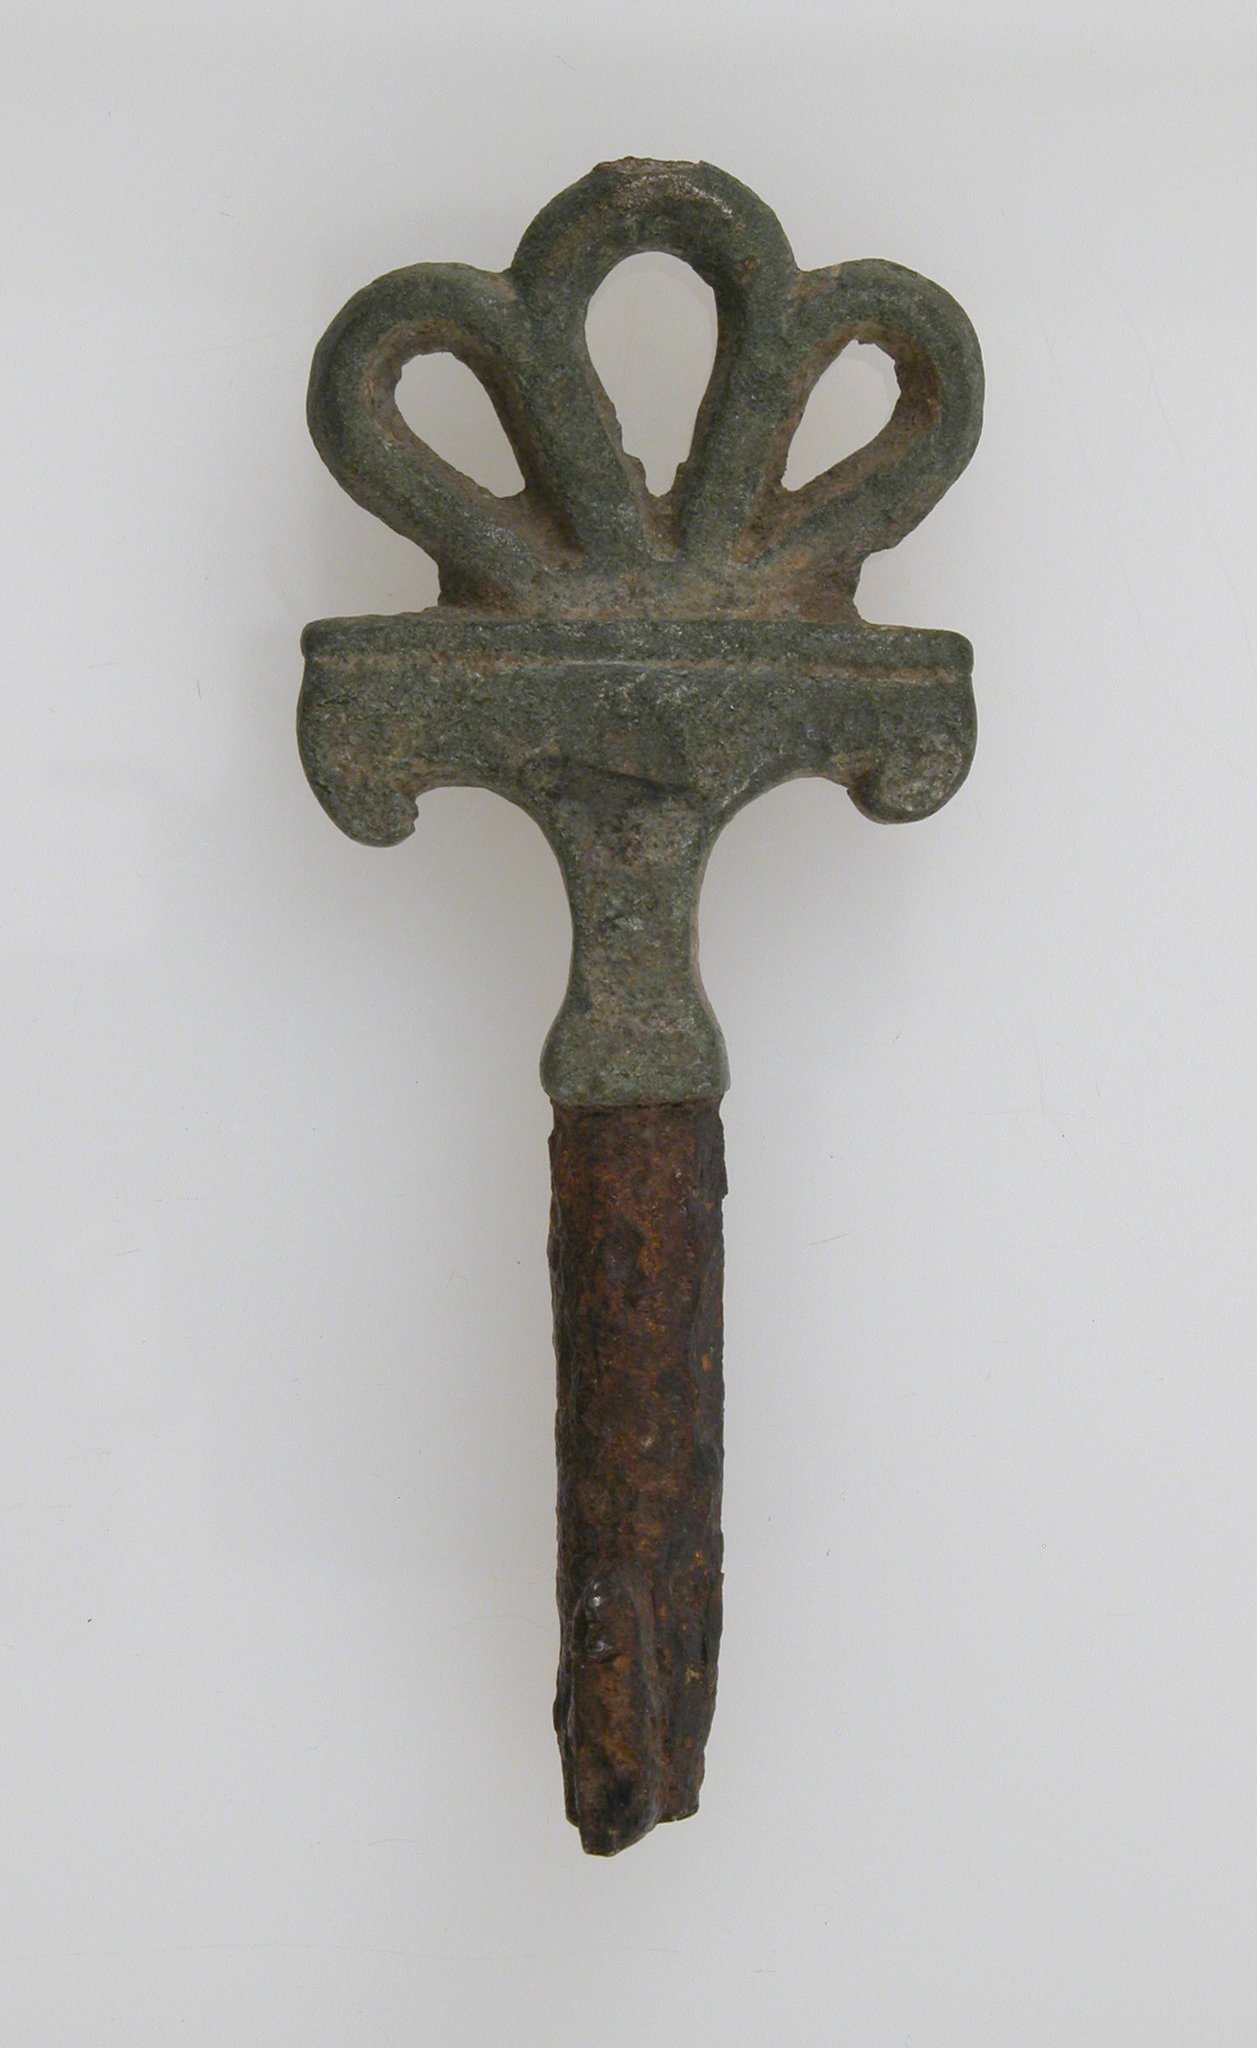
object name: key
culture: roman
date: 1-300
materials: copper alloy, iron